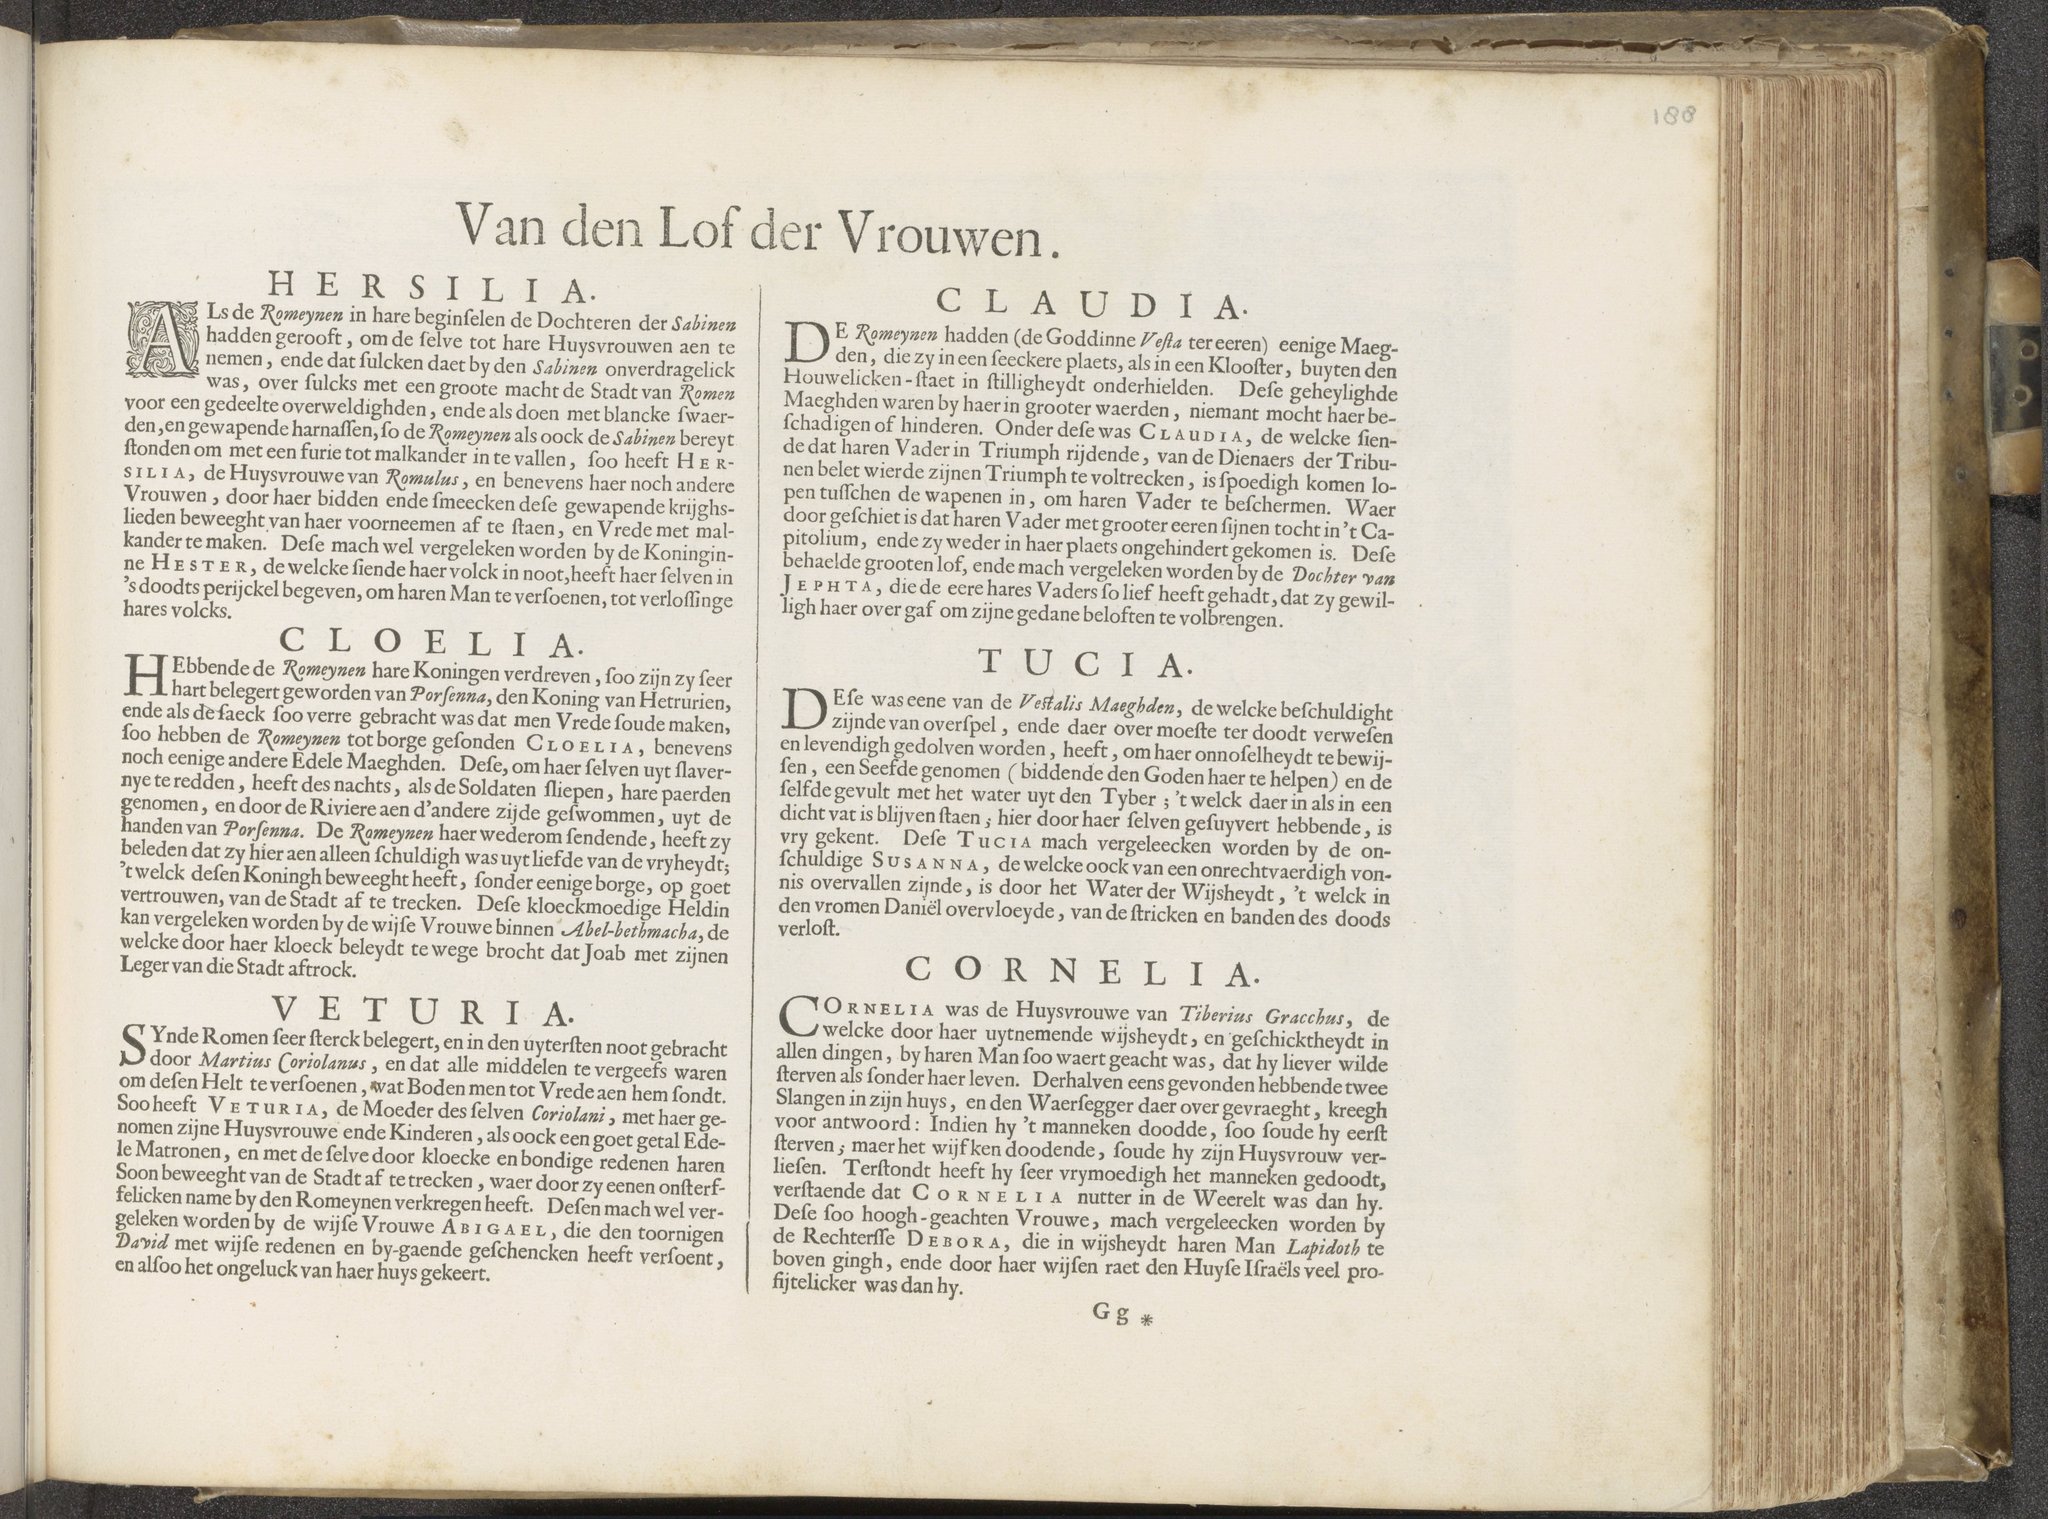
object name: album leaf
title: Van den lof der vrouwen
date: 1653-1654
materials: paper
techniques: letterpress printing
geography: amsterdam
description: Zes toelichtingen bij voorstellingen over beroemde Romeinse vrouwen: Hersilia, Cloelia, Vetura, Claudia, Tucia en Cornelia. De tekst vangt aan met een kleine gedecoreerde initiaal A. Het blad maakt deel uit van een album.